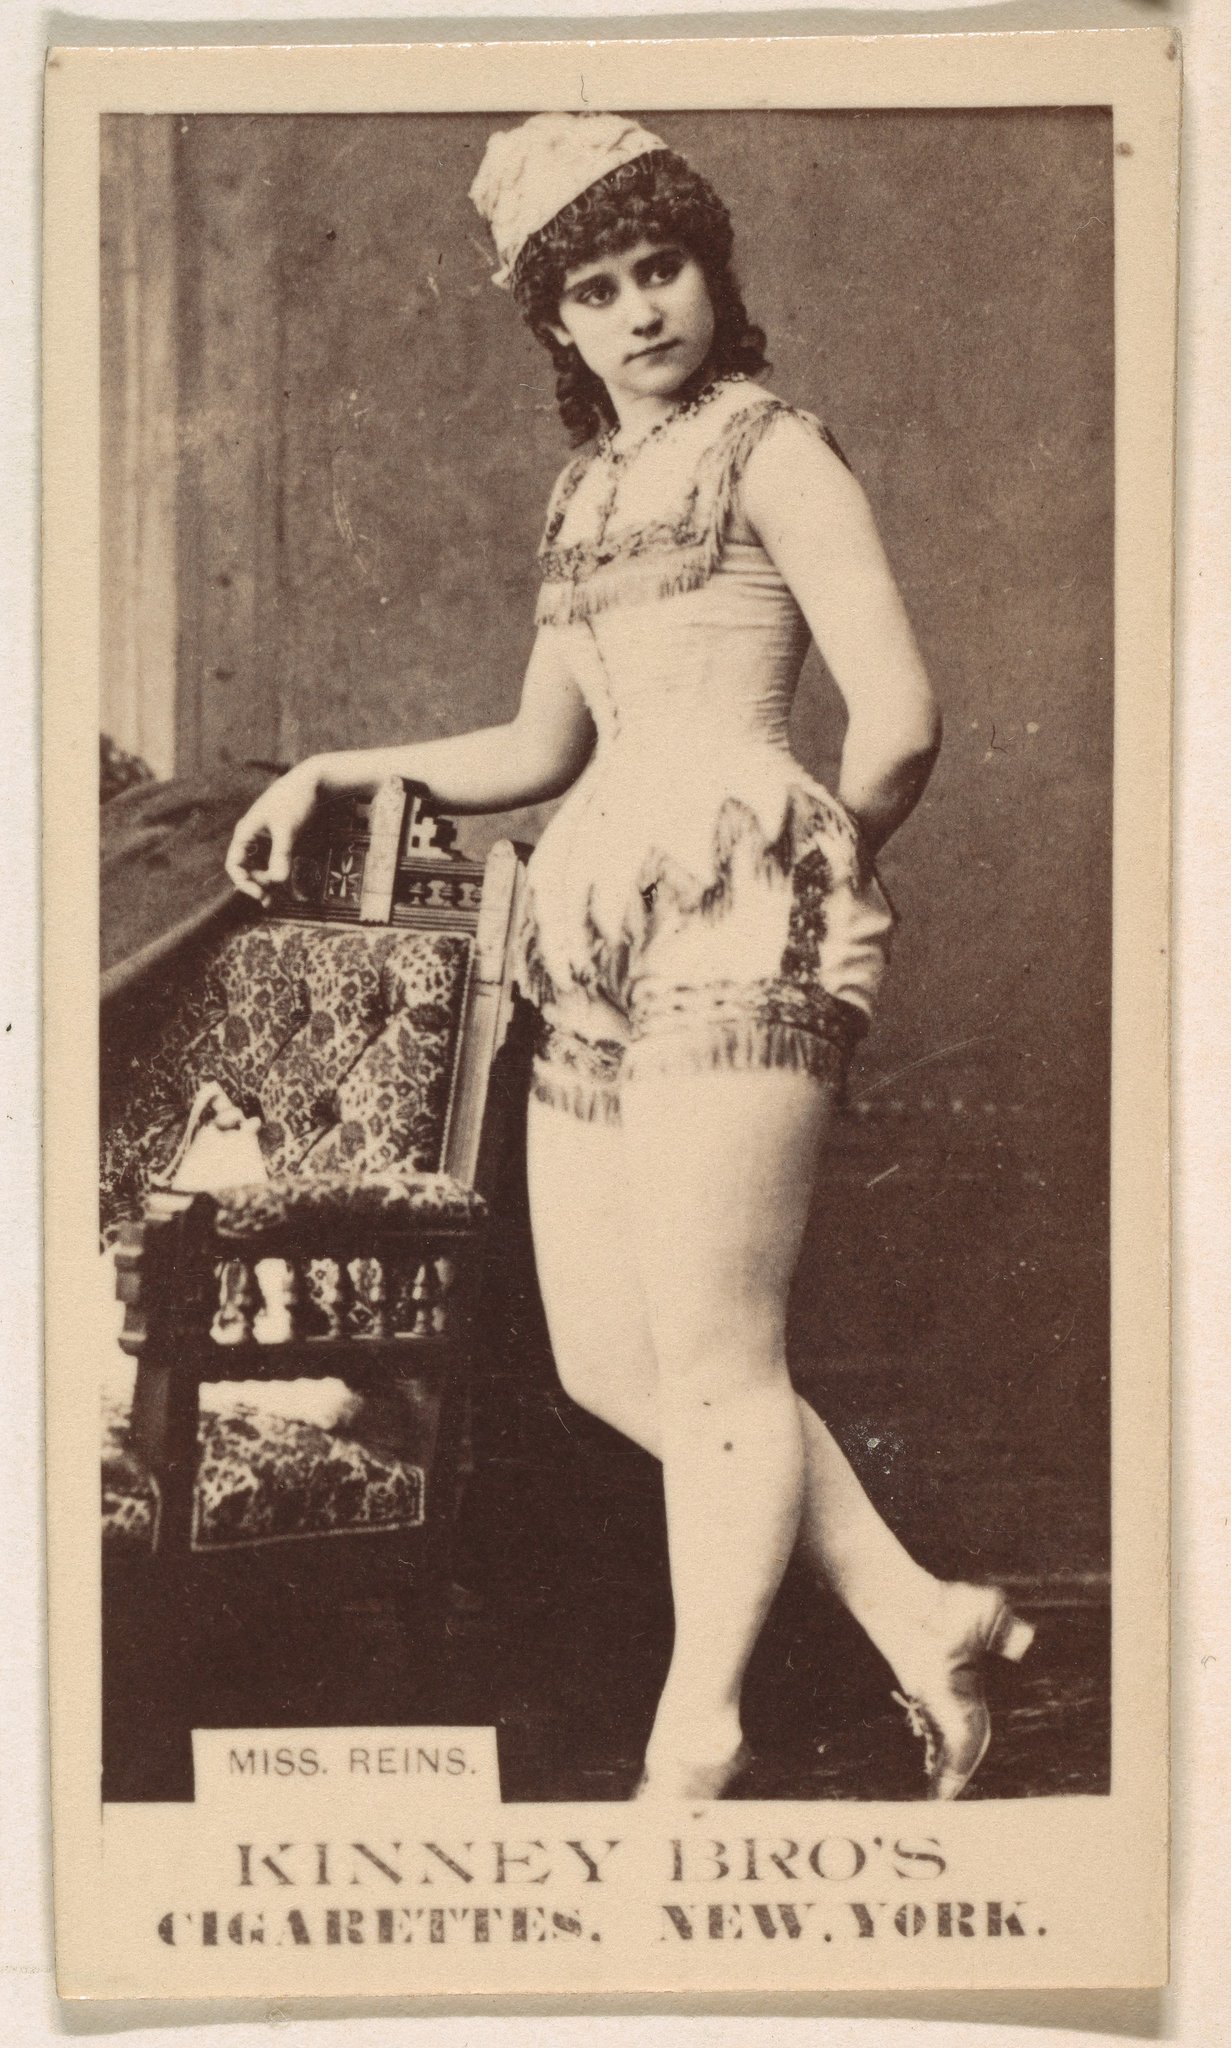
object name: photograph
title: Miss Reins, from the Actresses series (N245) issued by Kinney Brothers to promote Sweet Caporal Cigarettes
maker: kinney brothers tobacco company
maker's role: publisher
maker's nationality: american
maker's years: 1869-2011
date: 1890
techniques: albumen silver print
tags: portraits,women,actresses